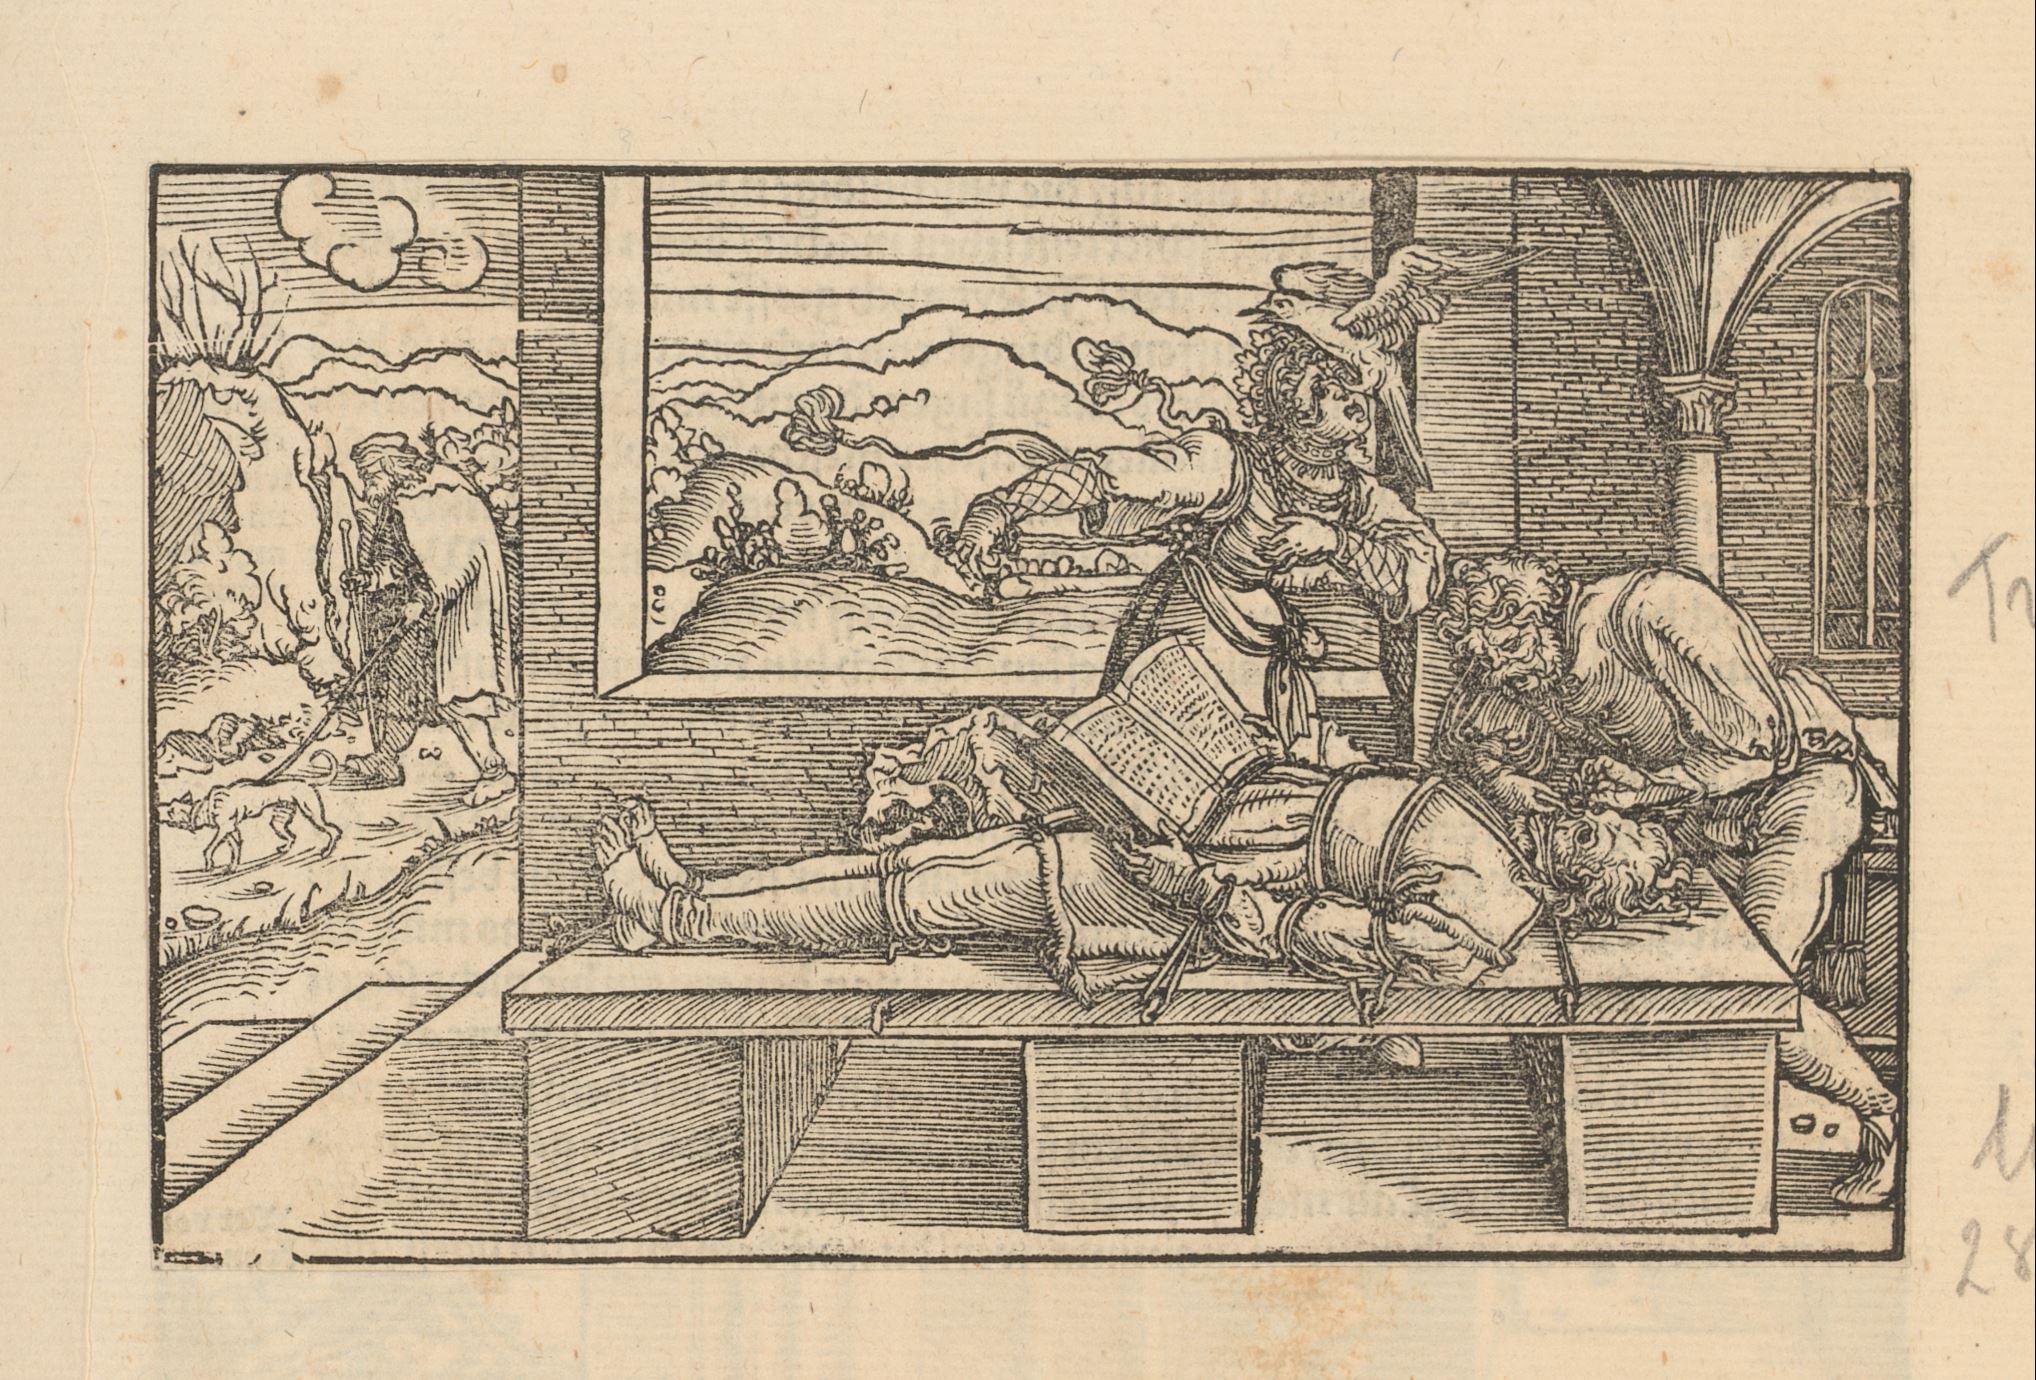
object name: album leaf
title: Allegorie op blindheid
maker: Anonymous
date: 1514-1532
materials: paper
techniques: letterpress printing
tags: birds (+ animal(s) attacking), blind, blindness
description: Deze prent is gebruikt in: Petrarca, Francesco. Von der Artzney bayder Glück, des guten und widerwertigen: unnd weß sich ain yeder inn Gelück und Unglück halten sol (...). Augsburg: Heinrich Steiner, 1532. Deze uitgave is ook bekend onder de titel 'Trostspiegel in Glück und Unglück'.